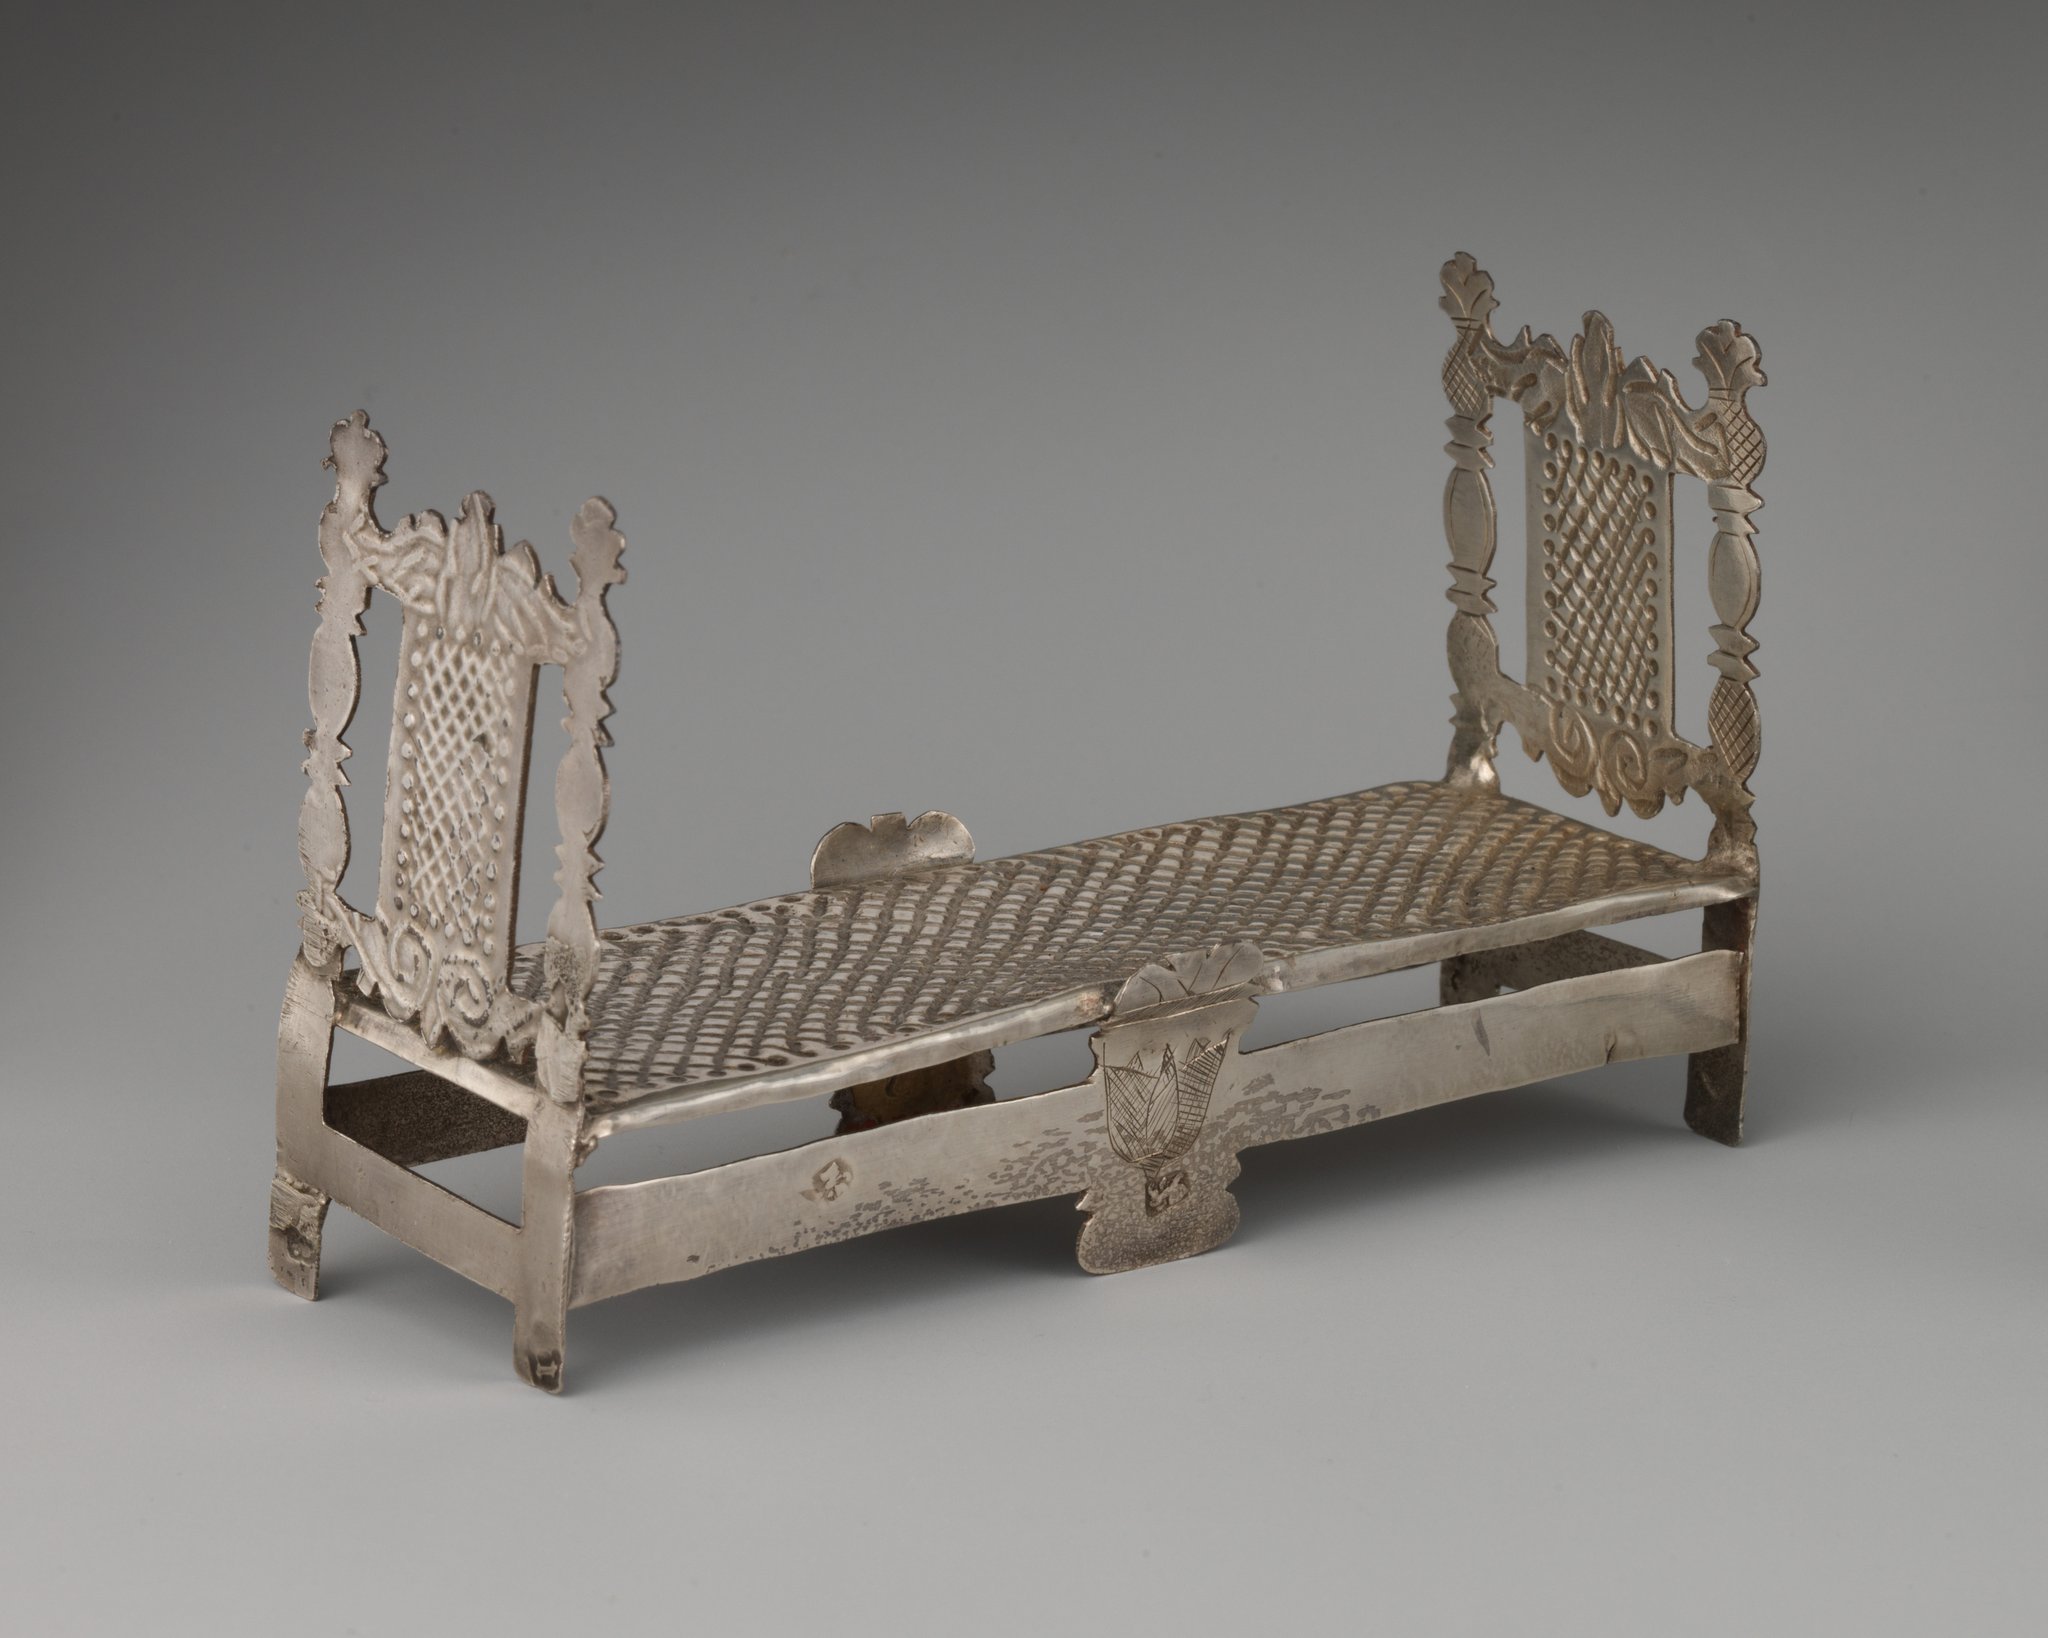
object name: daybed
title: Miniature daybed (part of a set)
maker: george manjoy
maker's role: maker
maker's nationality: british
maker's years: 1685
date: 1690-1691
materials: silver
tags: beds